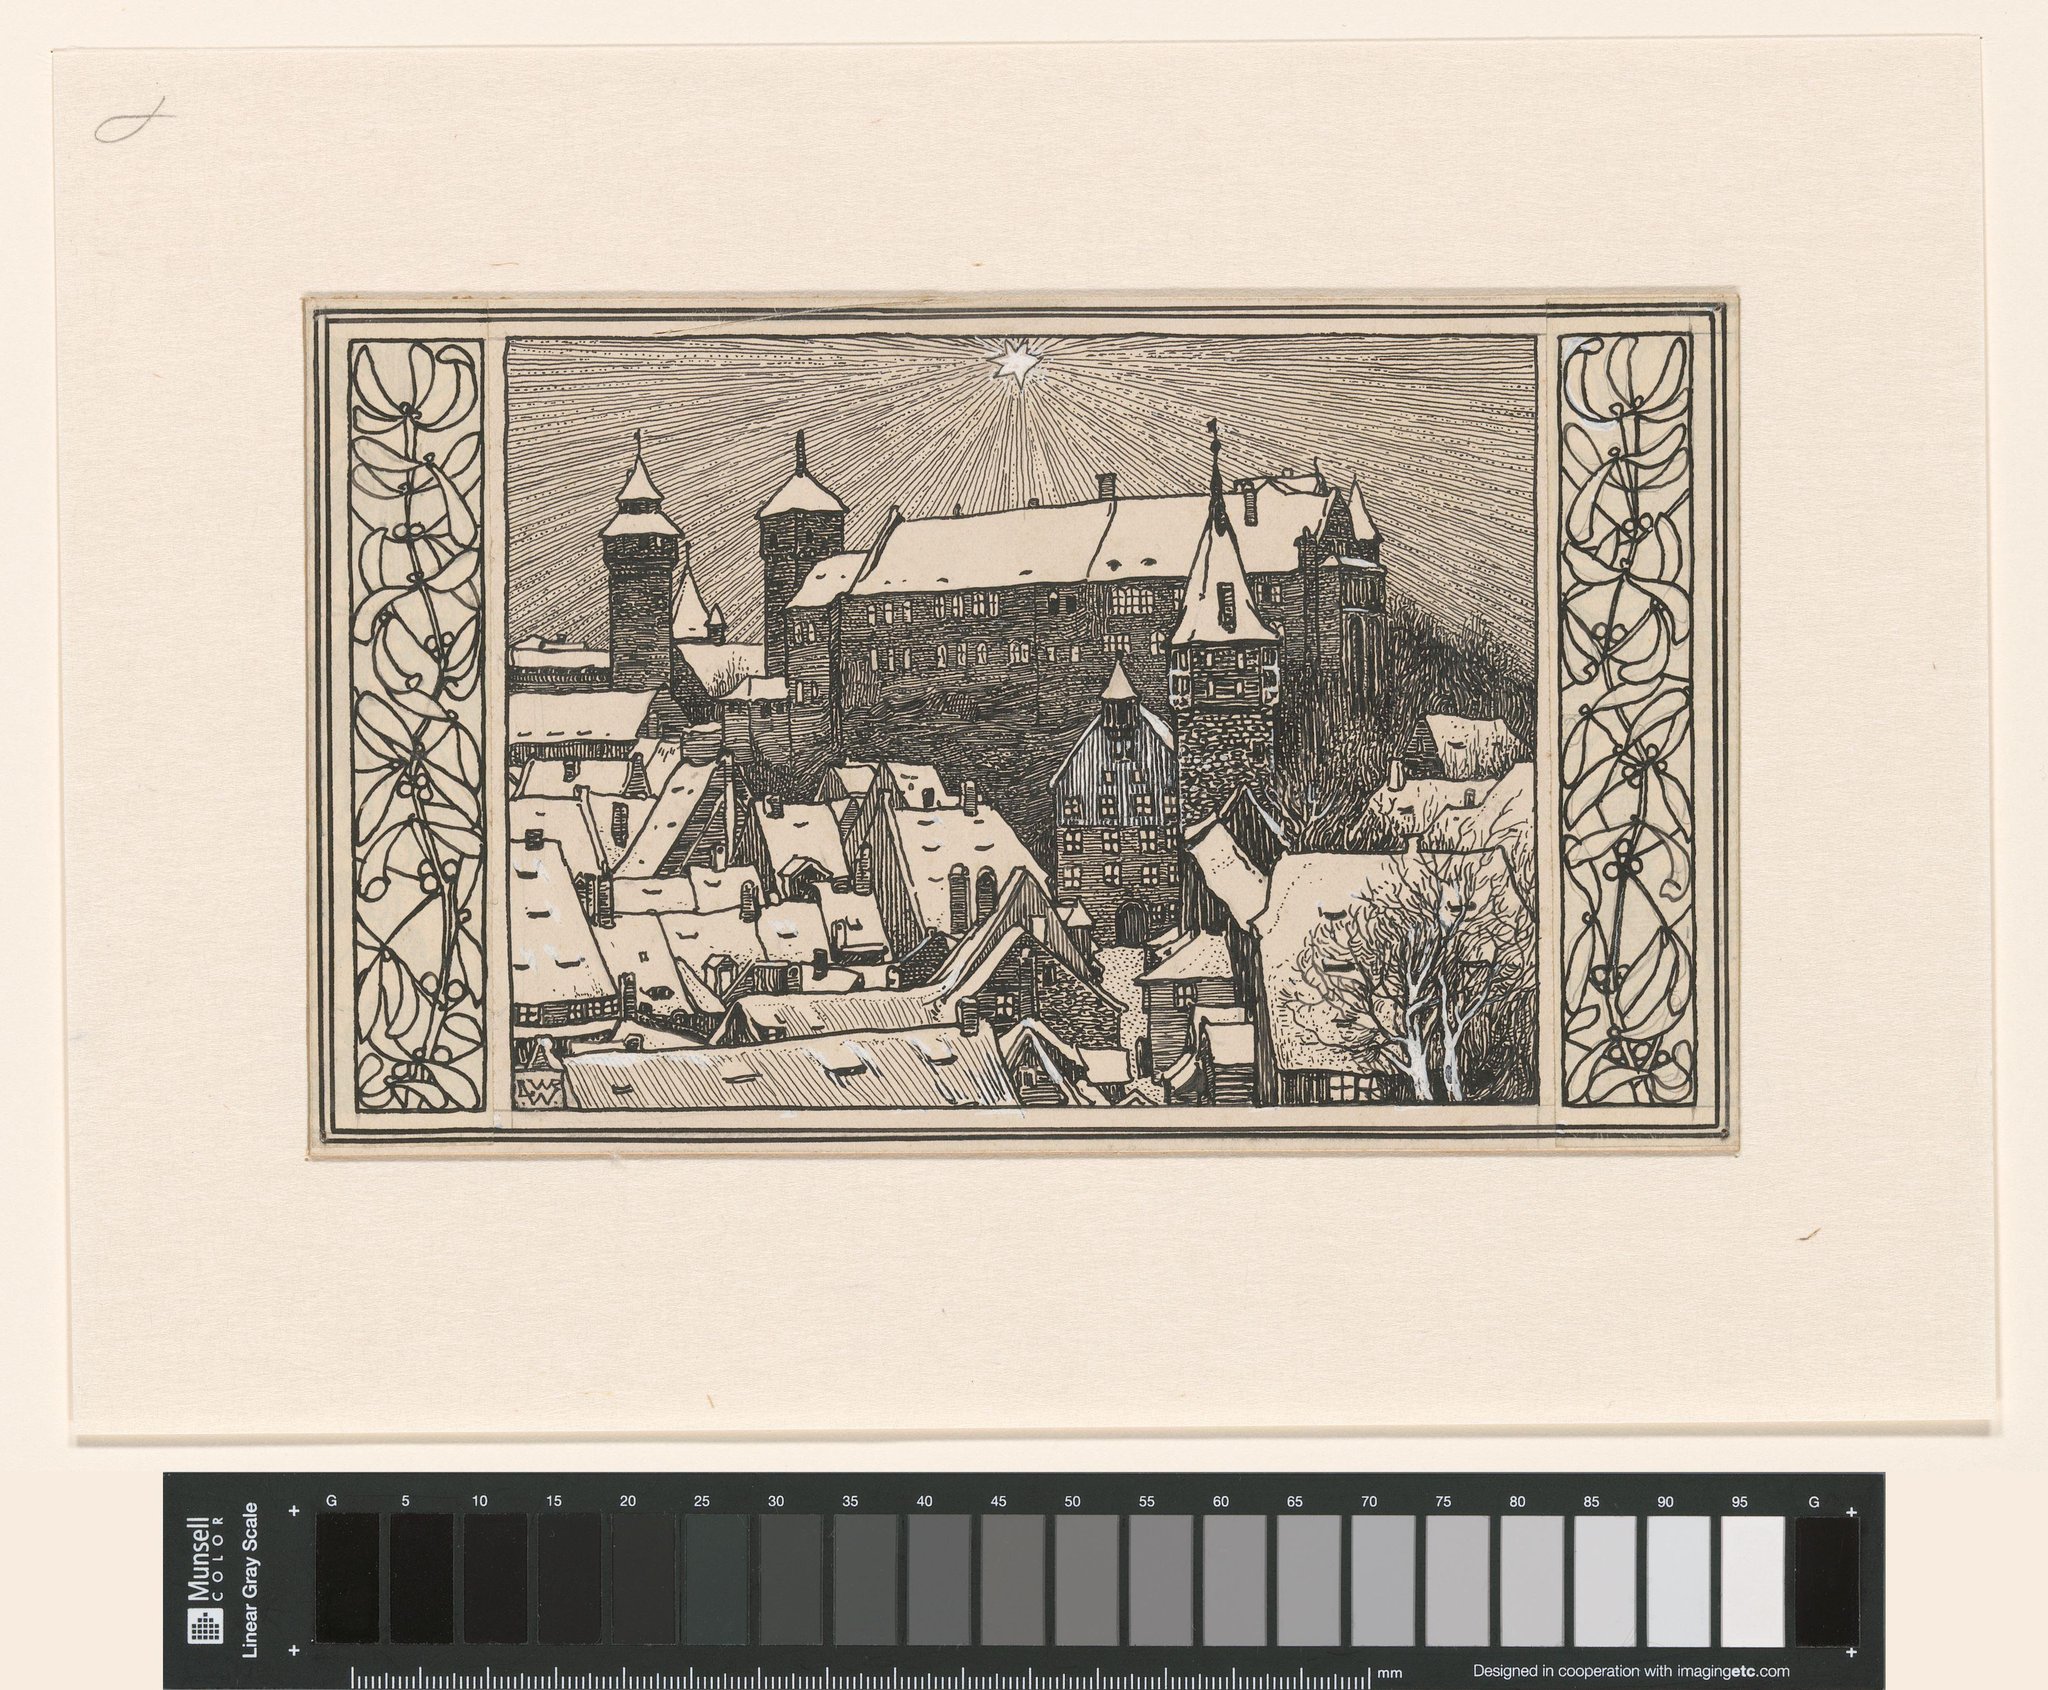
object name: boekillustratie ontwerp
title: Gezicht op een besneeuwd dorp bij avond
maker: willem wenckebach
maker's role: designer, draughtsman, painter, print maker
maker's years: 1860-1937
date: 1898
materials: paint, ink, paper, pencil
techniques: brush, pen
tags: prospect of village, silhouette of village, snow, stars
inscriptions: number: ‘no 174’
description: Ontwerp voor: Hoffman, Ernst Theodor Amadeus. Notenkraker en muizenkoning. Amsterdam: Scheltema & Holkema, 1898.